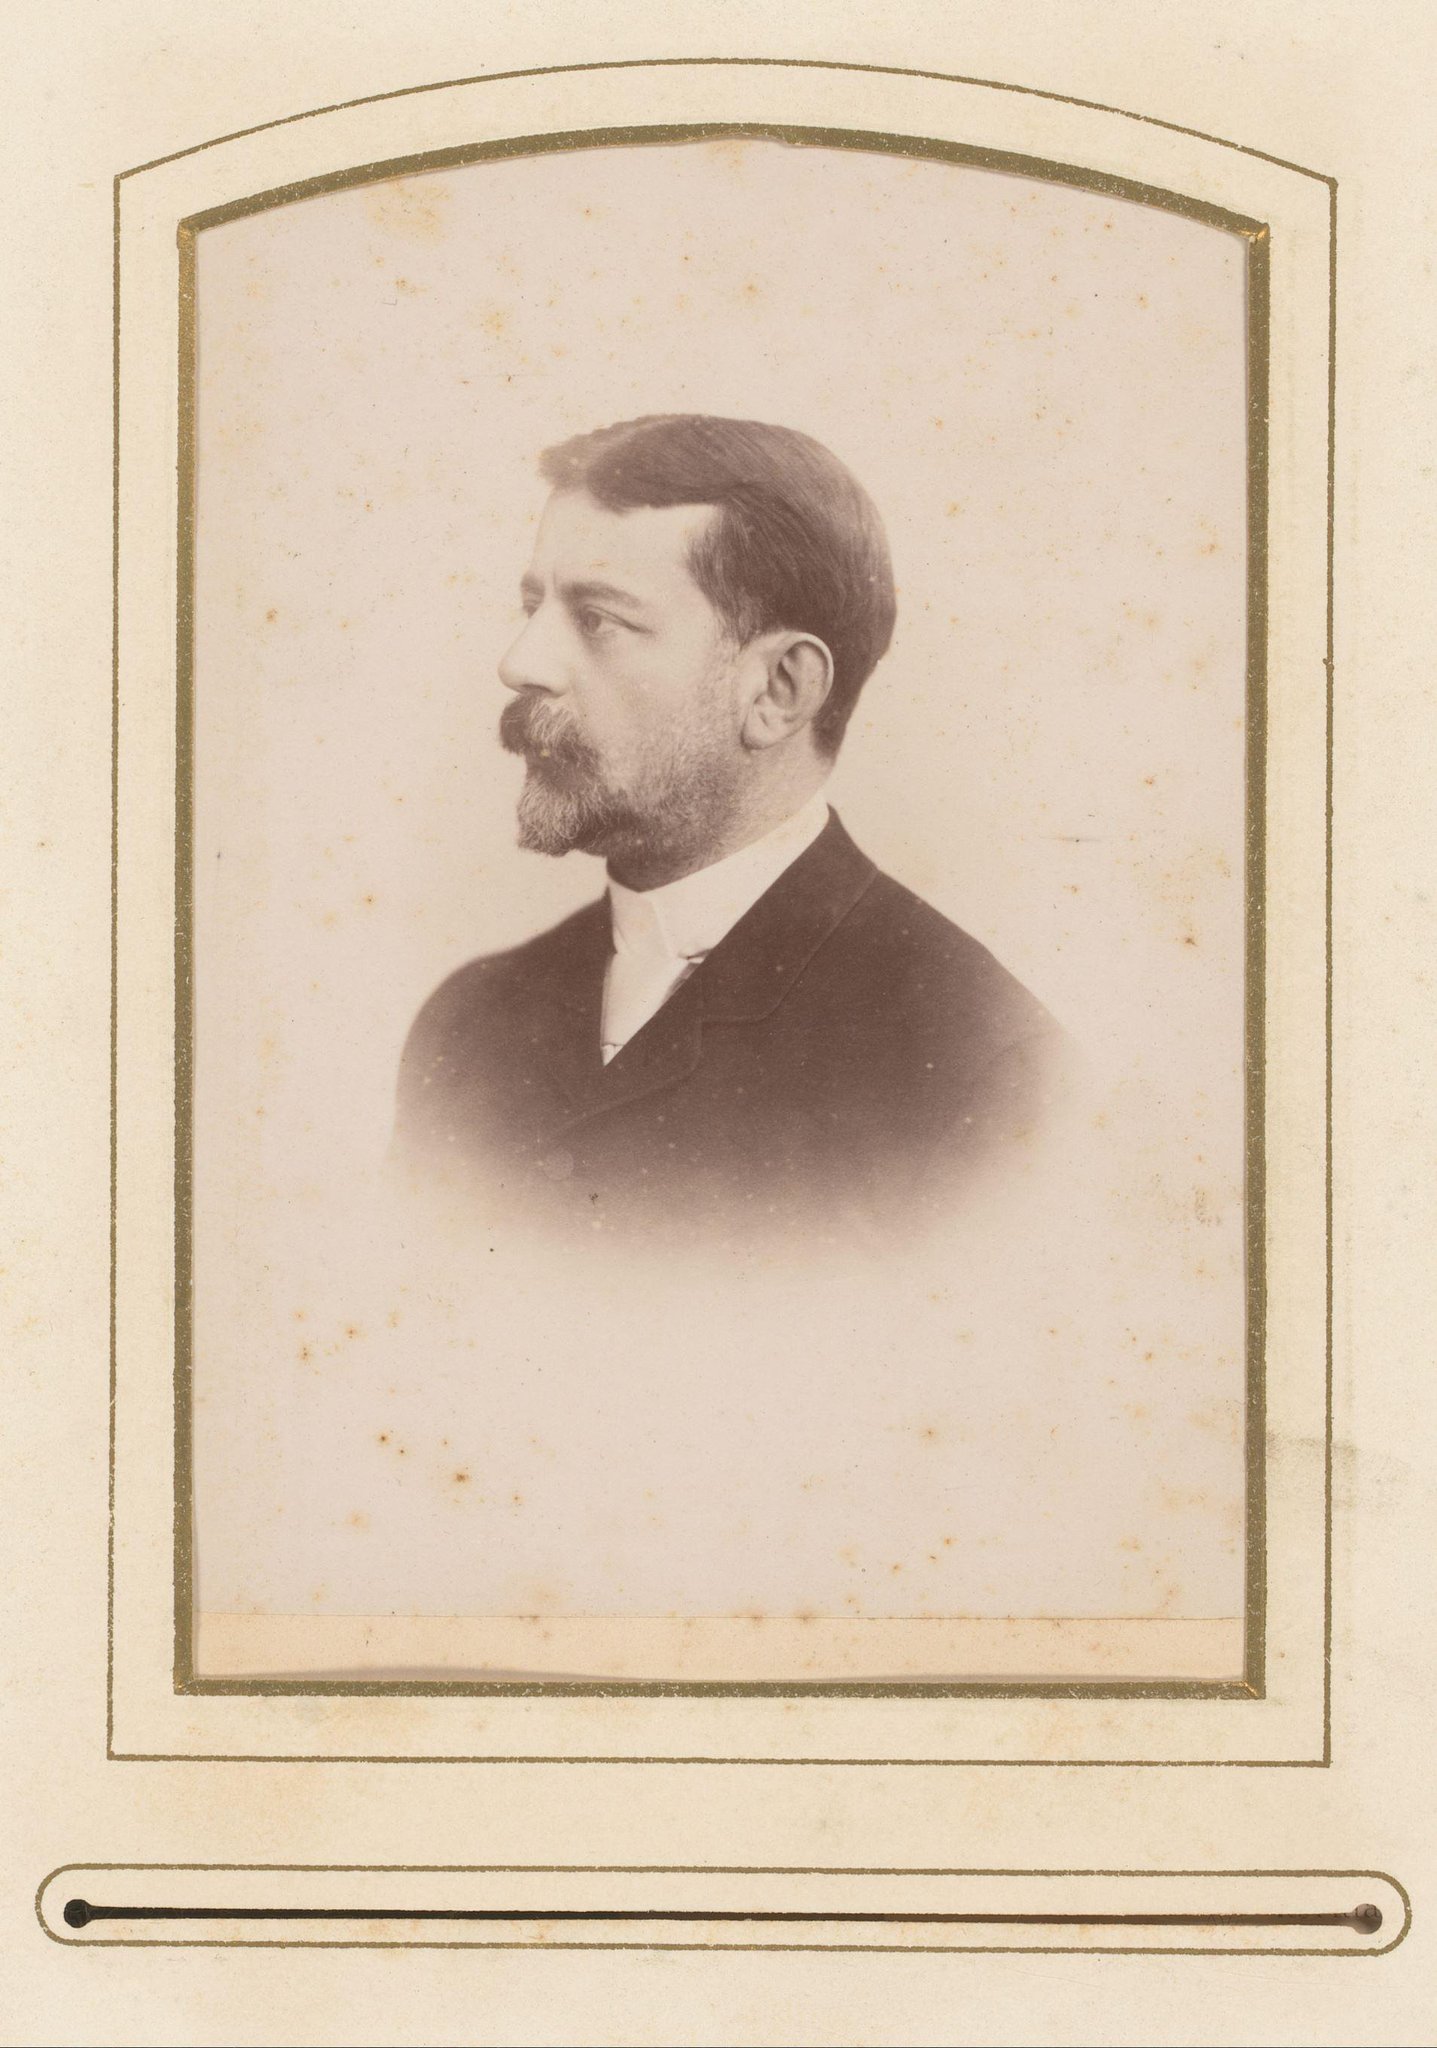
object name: photograph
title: Portret van een man met snor en baard, en profil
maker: clément bannel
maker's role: fotograaf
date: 1850-1900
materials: cardboard, photographic support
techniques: albumen print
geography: paris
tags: moustache, historical persons, beard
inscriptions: inscription: ‘Peintures, Photographies, Pastels/ Emaux - Reproductions/ A. Bannel/ 6, Boulevard des Italiens/ Paris/ (Ancienne Maison Disderi)’